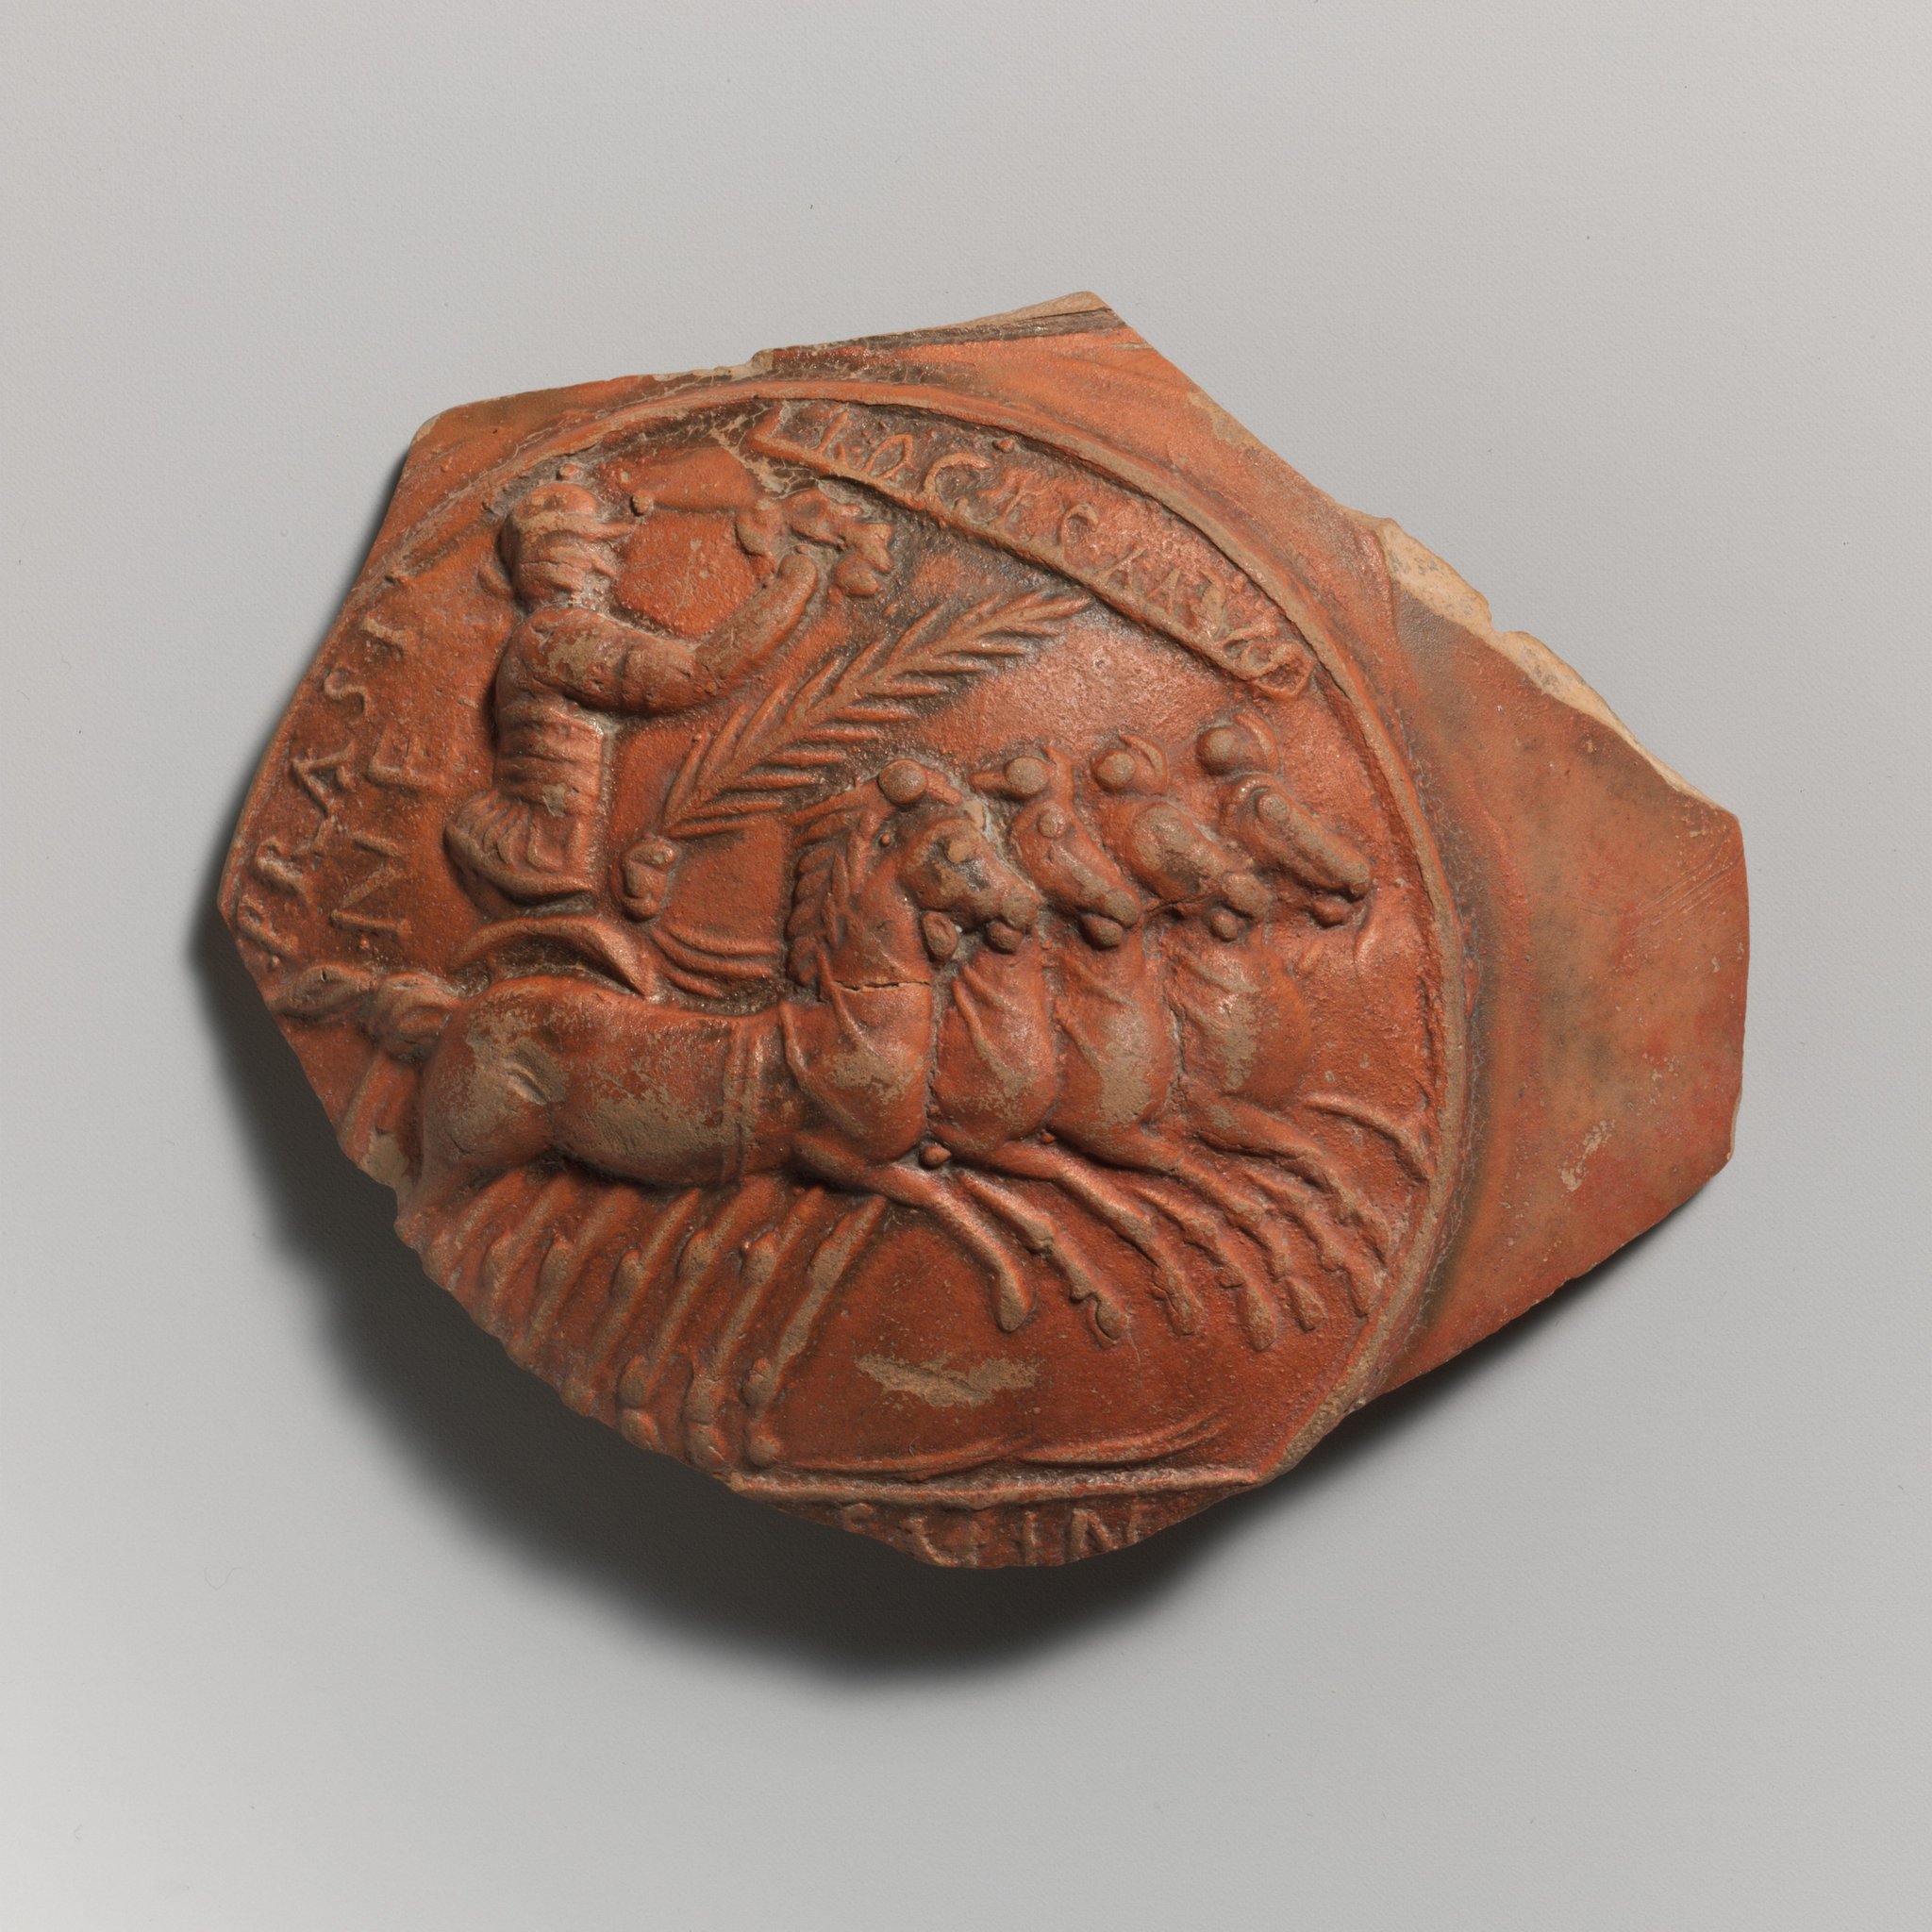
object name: medallion, fragment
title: Terracotta medallion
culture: roman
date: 167-233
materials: terracotta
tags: men,horses,chariots